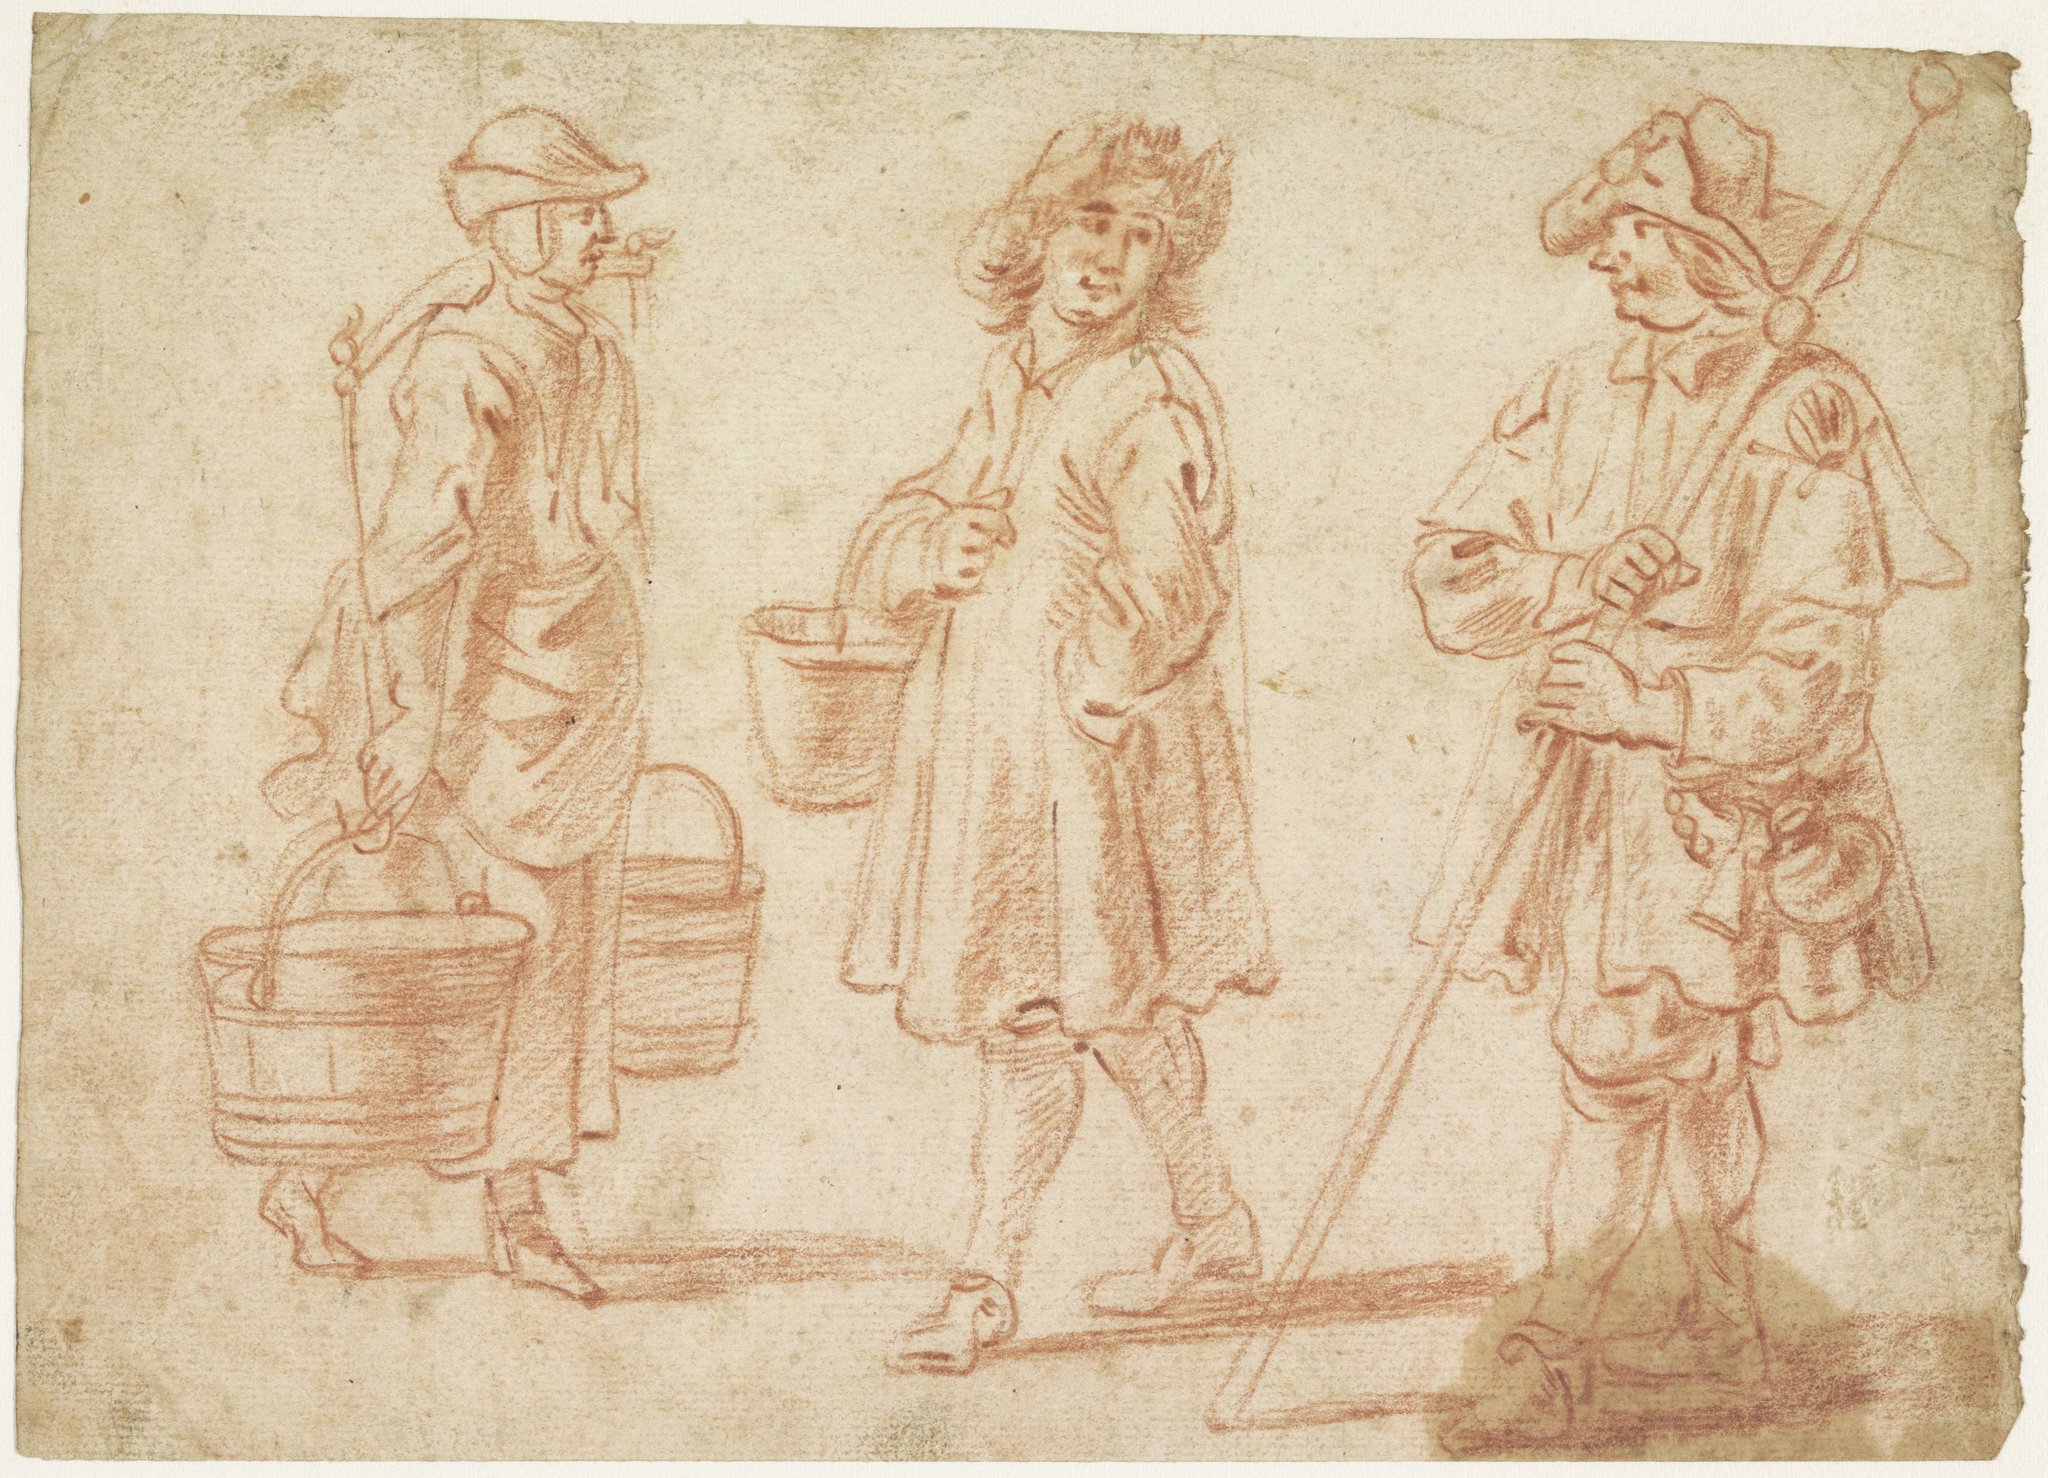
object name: drawing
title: Drie schetsen van een vrouw met juk, man met emmer en een pelgrim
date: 1690-1731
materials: chalk, paper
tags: pilgrim(s), carrying something with yoke